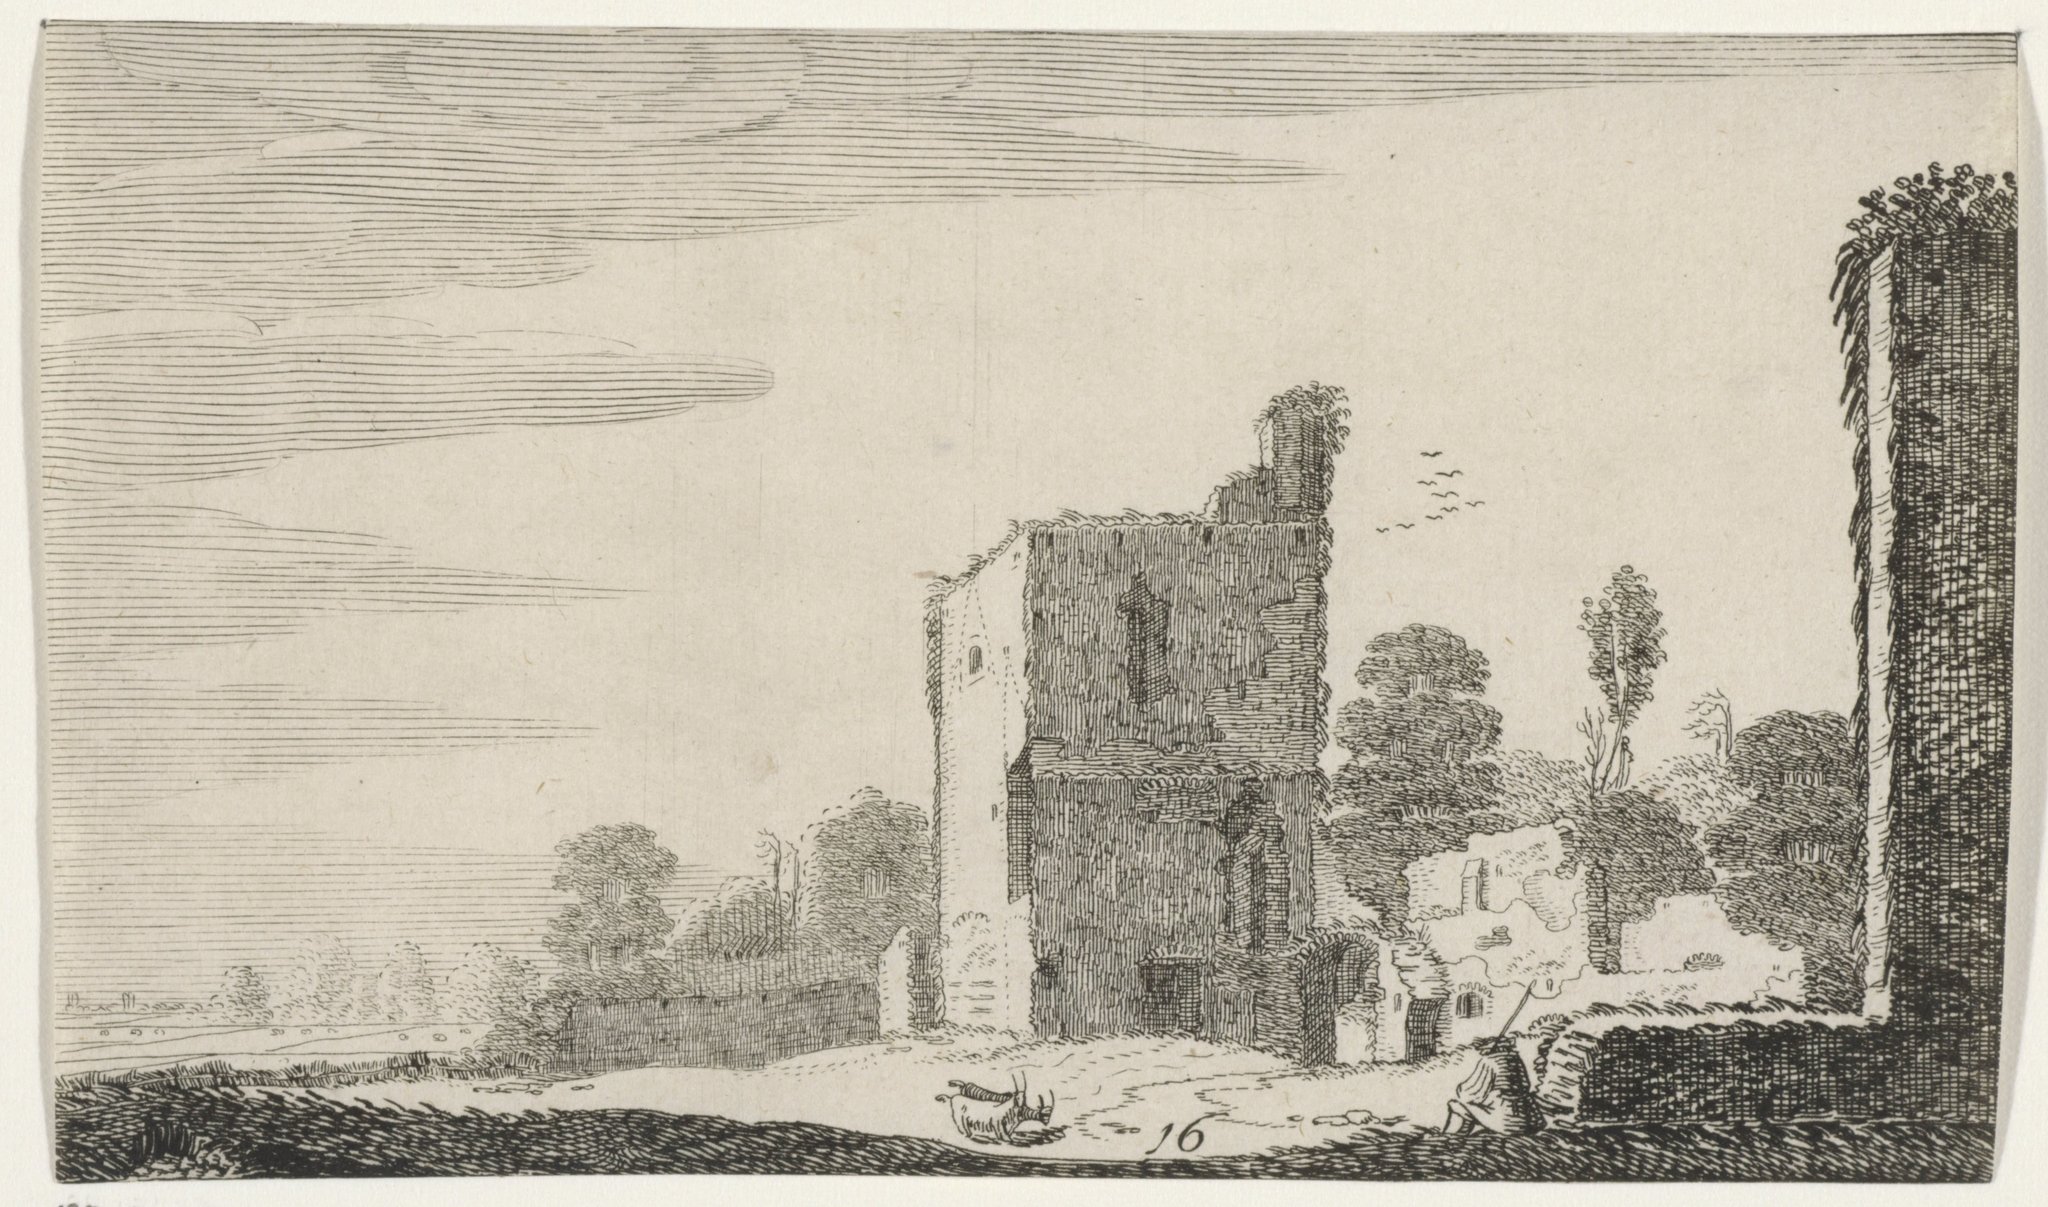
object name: print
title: Ruïnes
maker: jan van de velde (ii)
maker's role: draughtsman, painter, print maker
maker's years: 1593-1641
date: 1616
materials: paper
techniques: engraving, etching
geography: northern netherlands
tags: herding, herdsman, herdswoman, shepherd, shepherdess, cowherd, etc., landscape with ruins, landscape with tower or castle, ruin of a dwelling, house, castle, etc.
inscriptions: collector's mark: Lugt 240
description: Een zittende herder bij een ruïne van een toren in een landschap. Zestiende prent uit een serie van twintig.